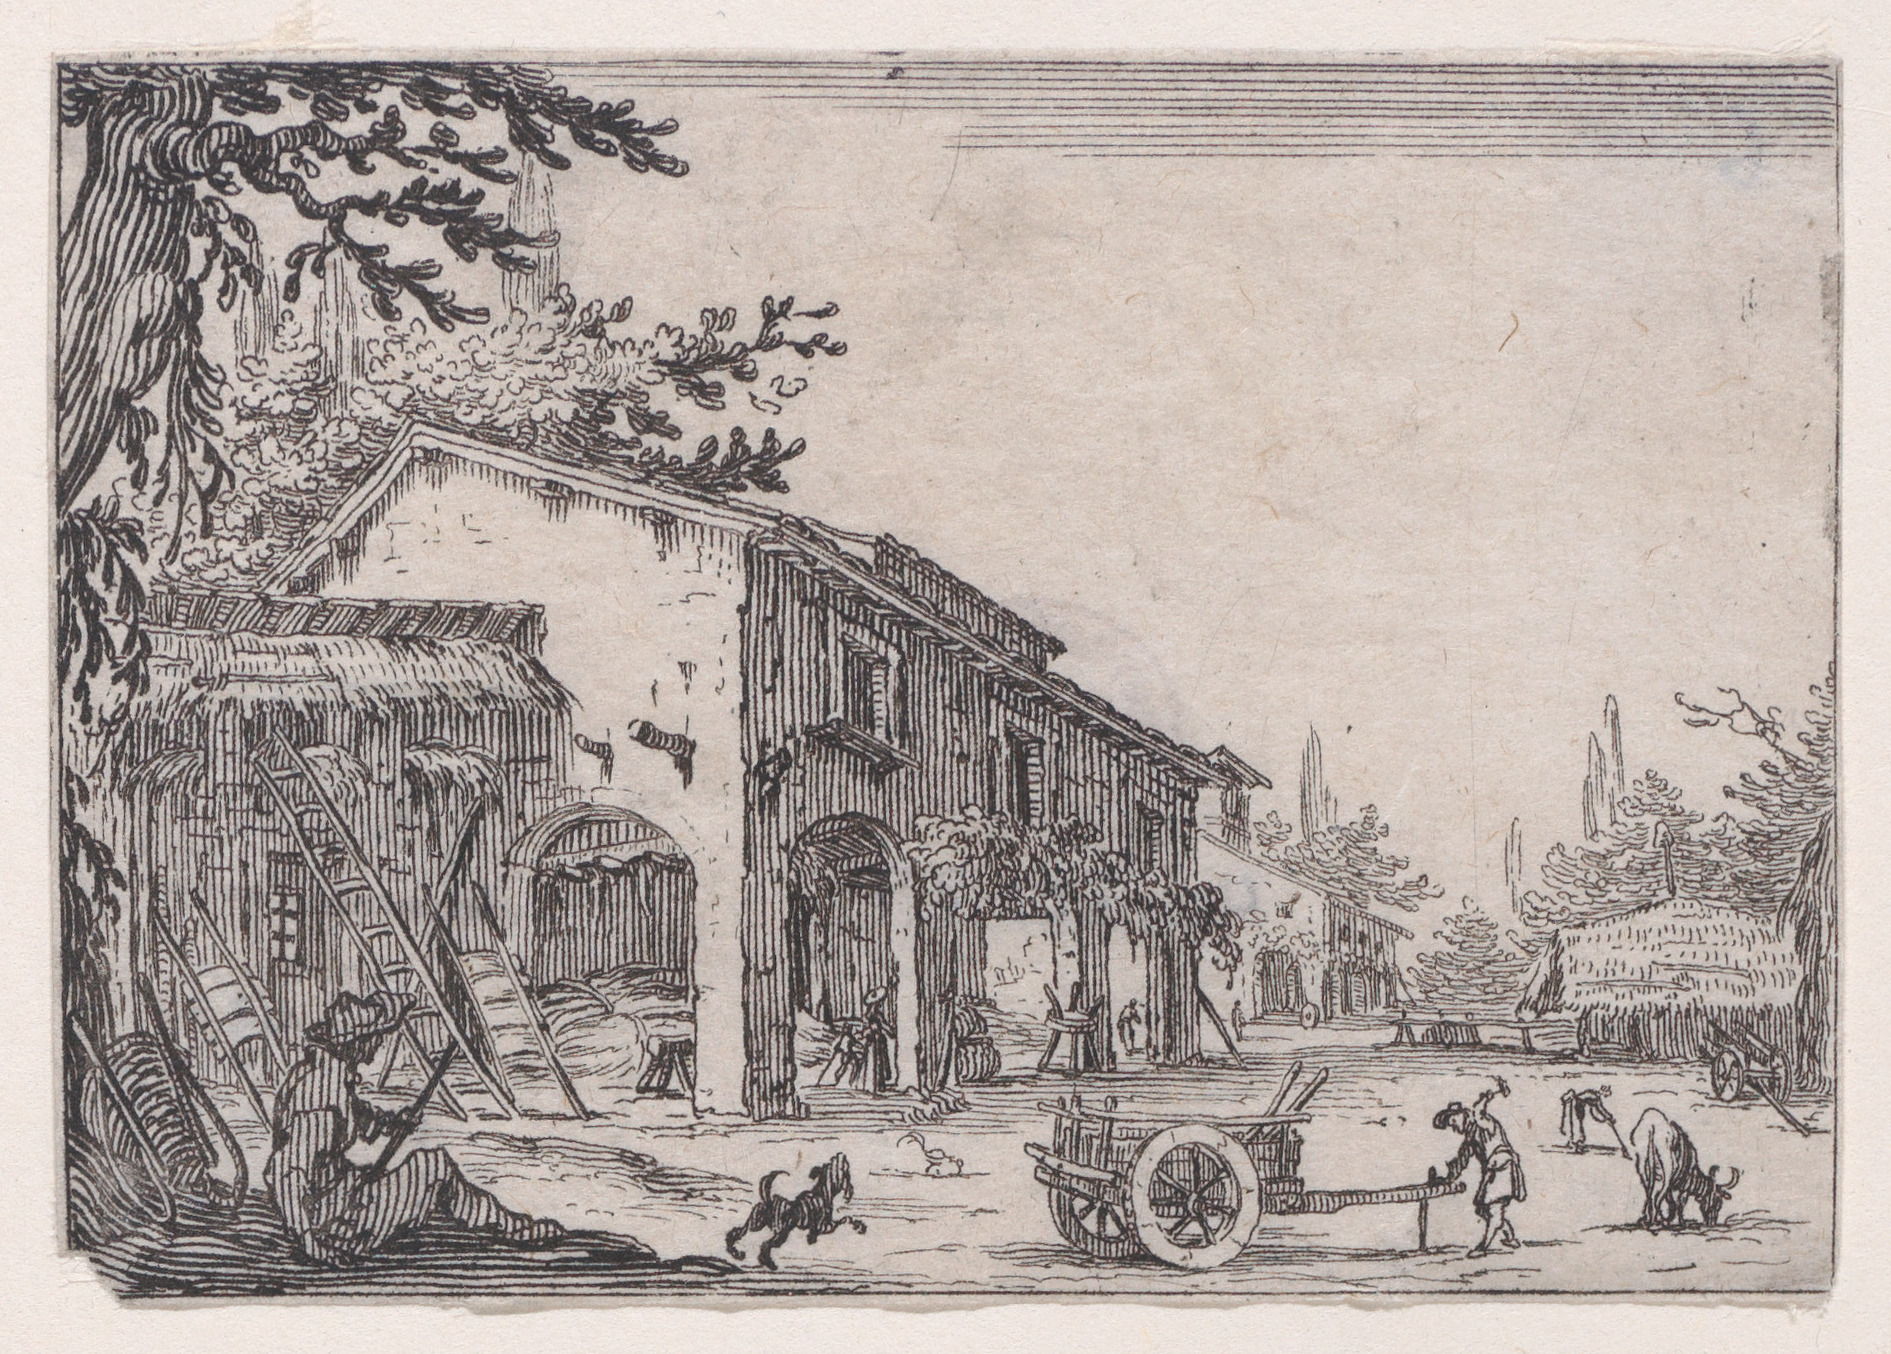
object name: print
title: La Factoria (The Factory), from "Les Caprices" Series B, The Nancy Set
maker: jacques callot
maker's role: artist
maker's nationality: french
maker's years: 1592-1635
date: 1617-1620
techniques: etching